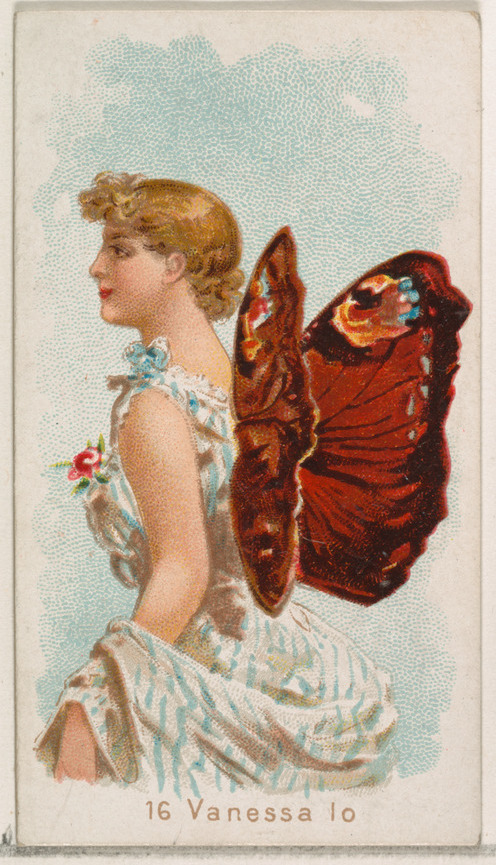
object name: print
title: Card 16, Vanessa Io, from the Butterflies series (N183) issued by Wm. S. Kimball & Co.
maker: william s. kimball & company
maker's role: publisher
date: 1888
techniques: color lithograph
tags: profiles,women,butterflies